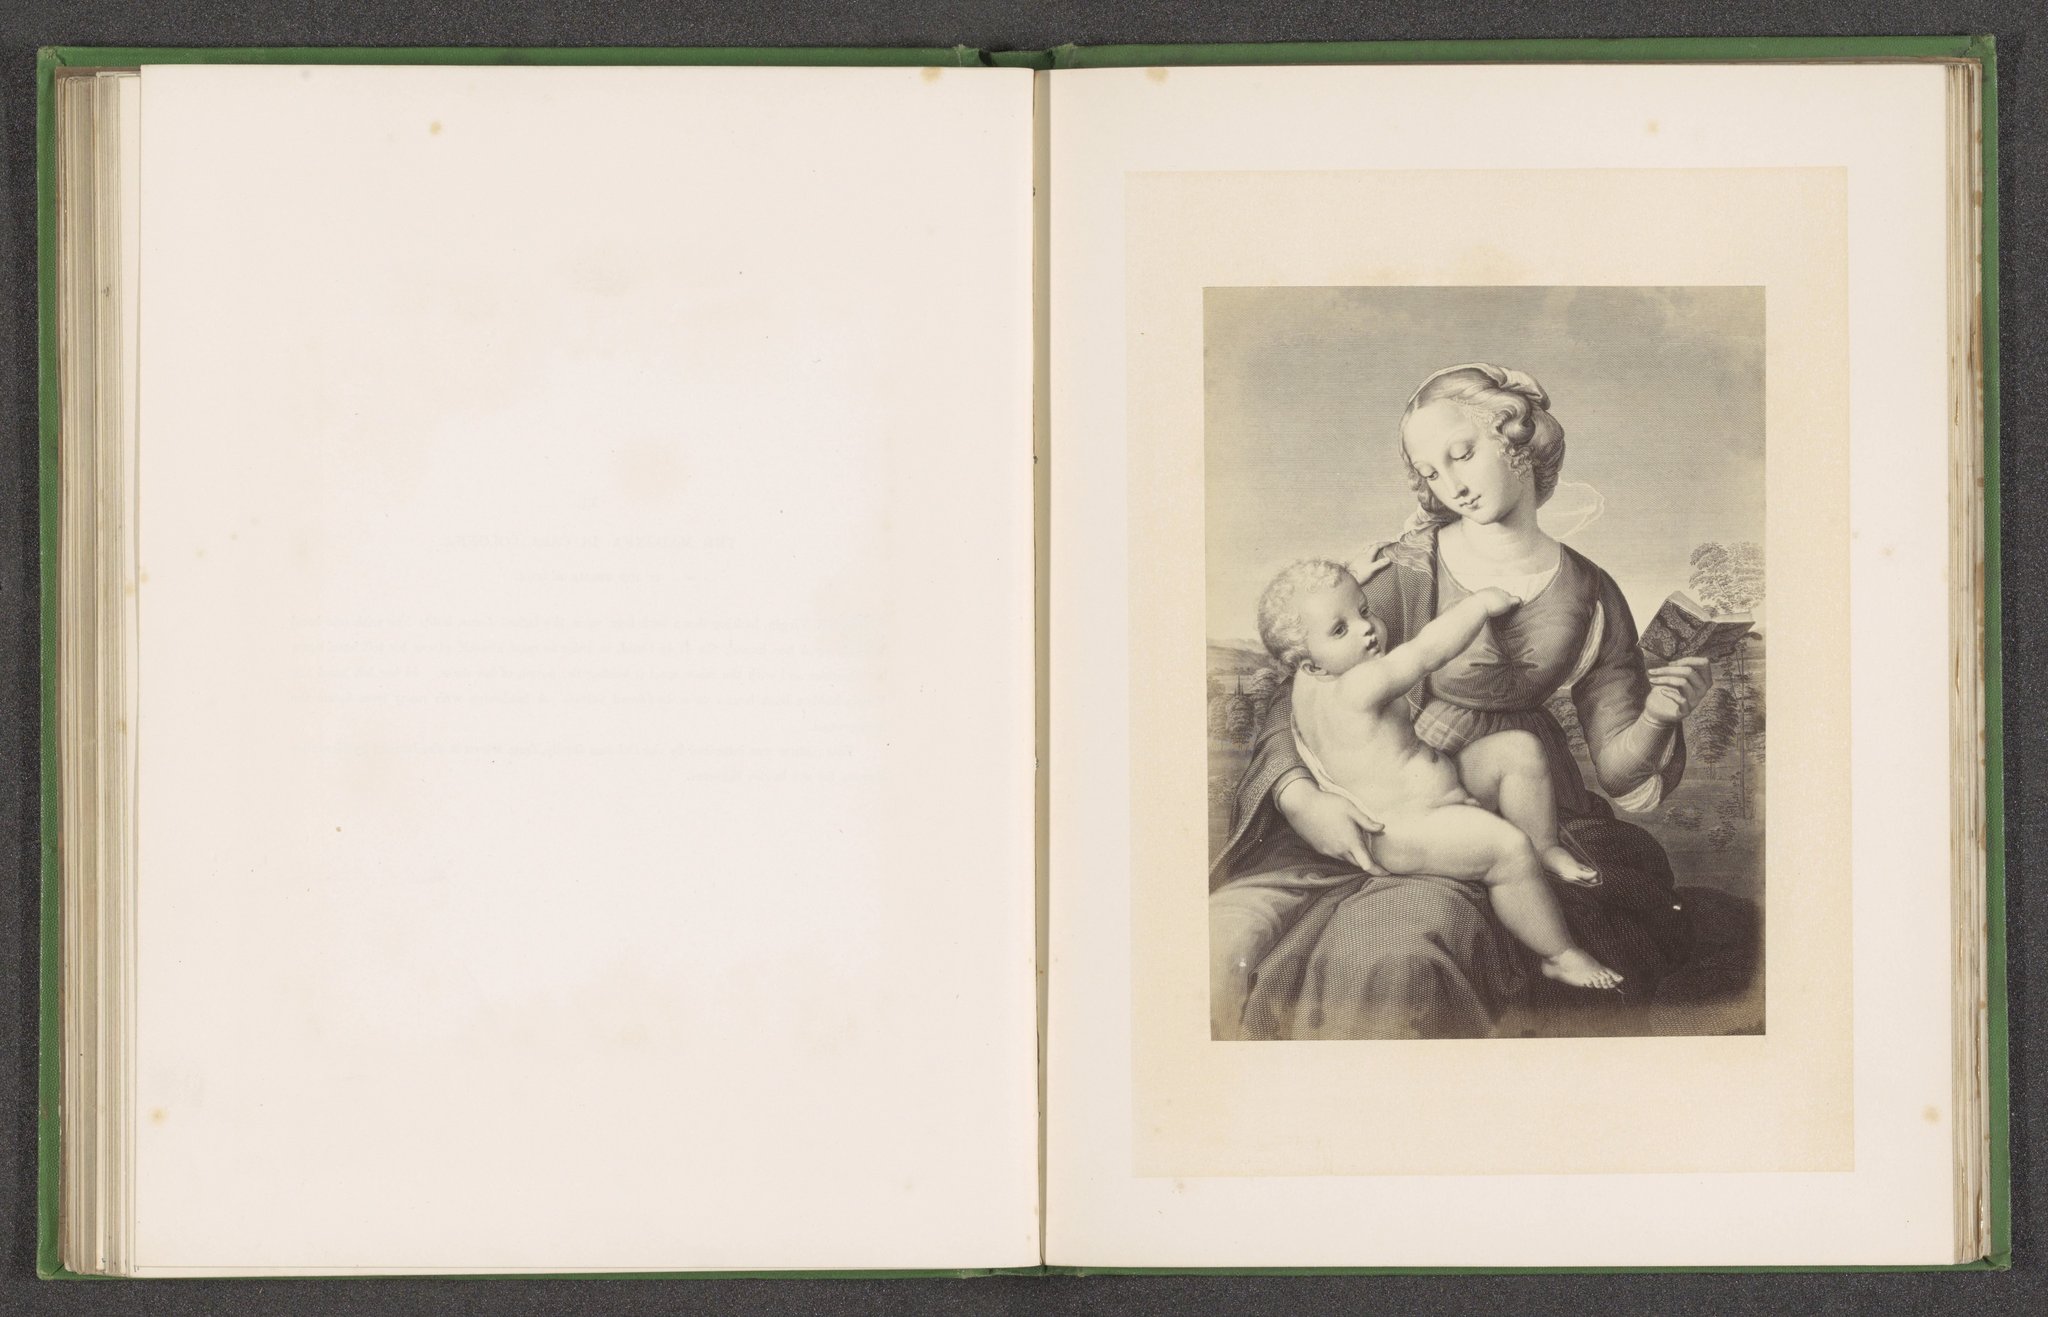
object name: photograph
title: Fotoreproductie van een prent door Eduard Mandel van de Madonna Colonna door Rafaël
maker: joseph cundall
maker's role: fotograaf, schrijver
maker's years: 1818-1895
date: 1859-1869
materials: photographic support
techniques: albumen print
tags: madonna: i.e. mary with the christ-child